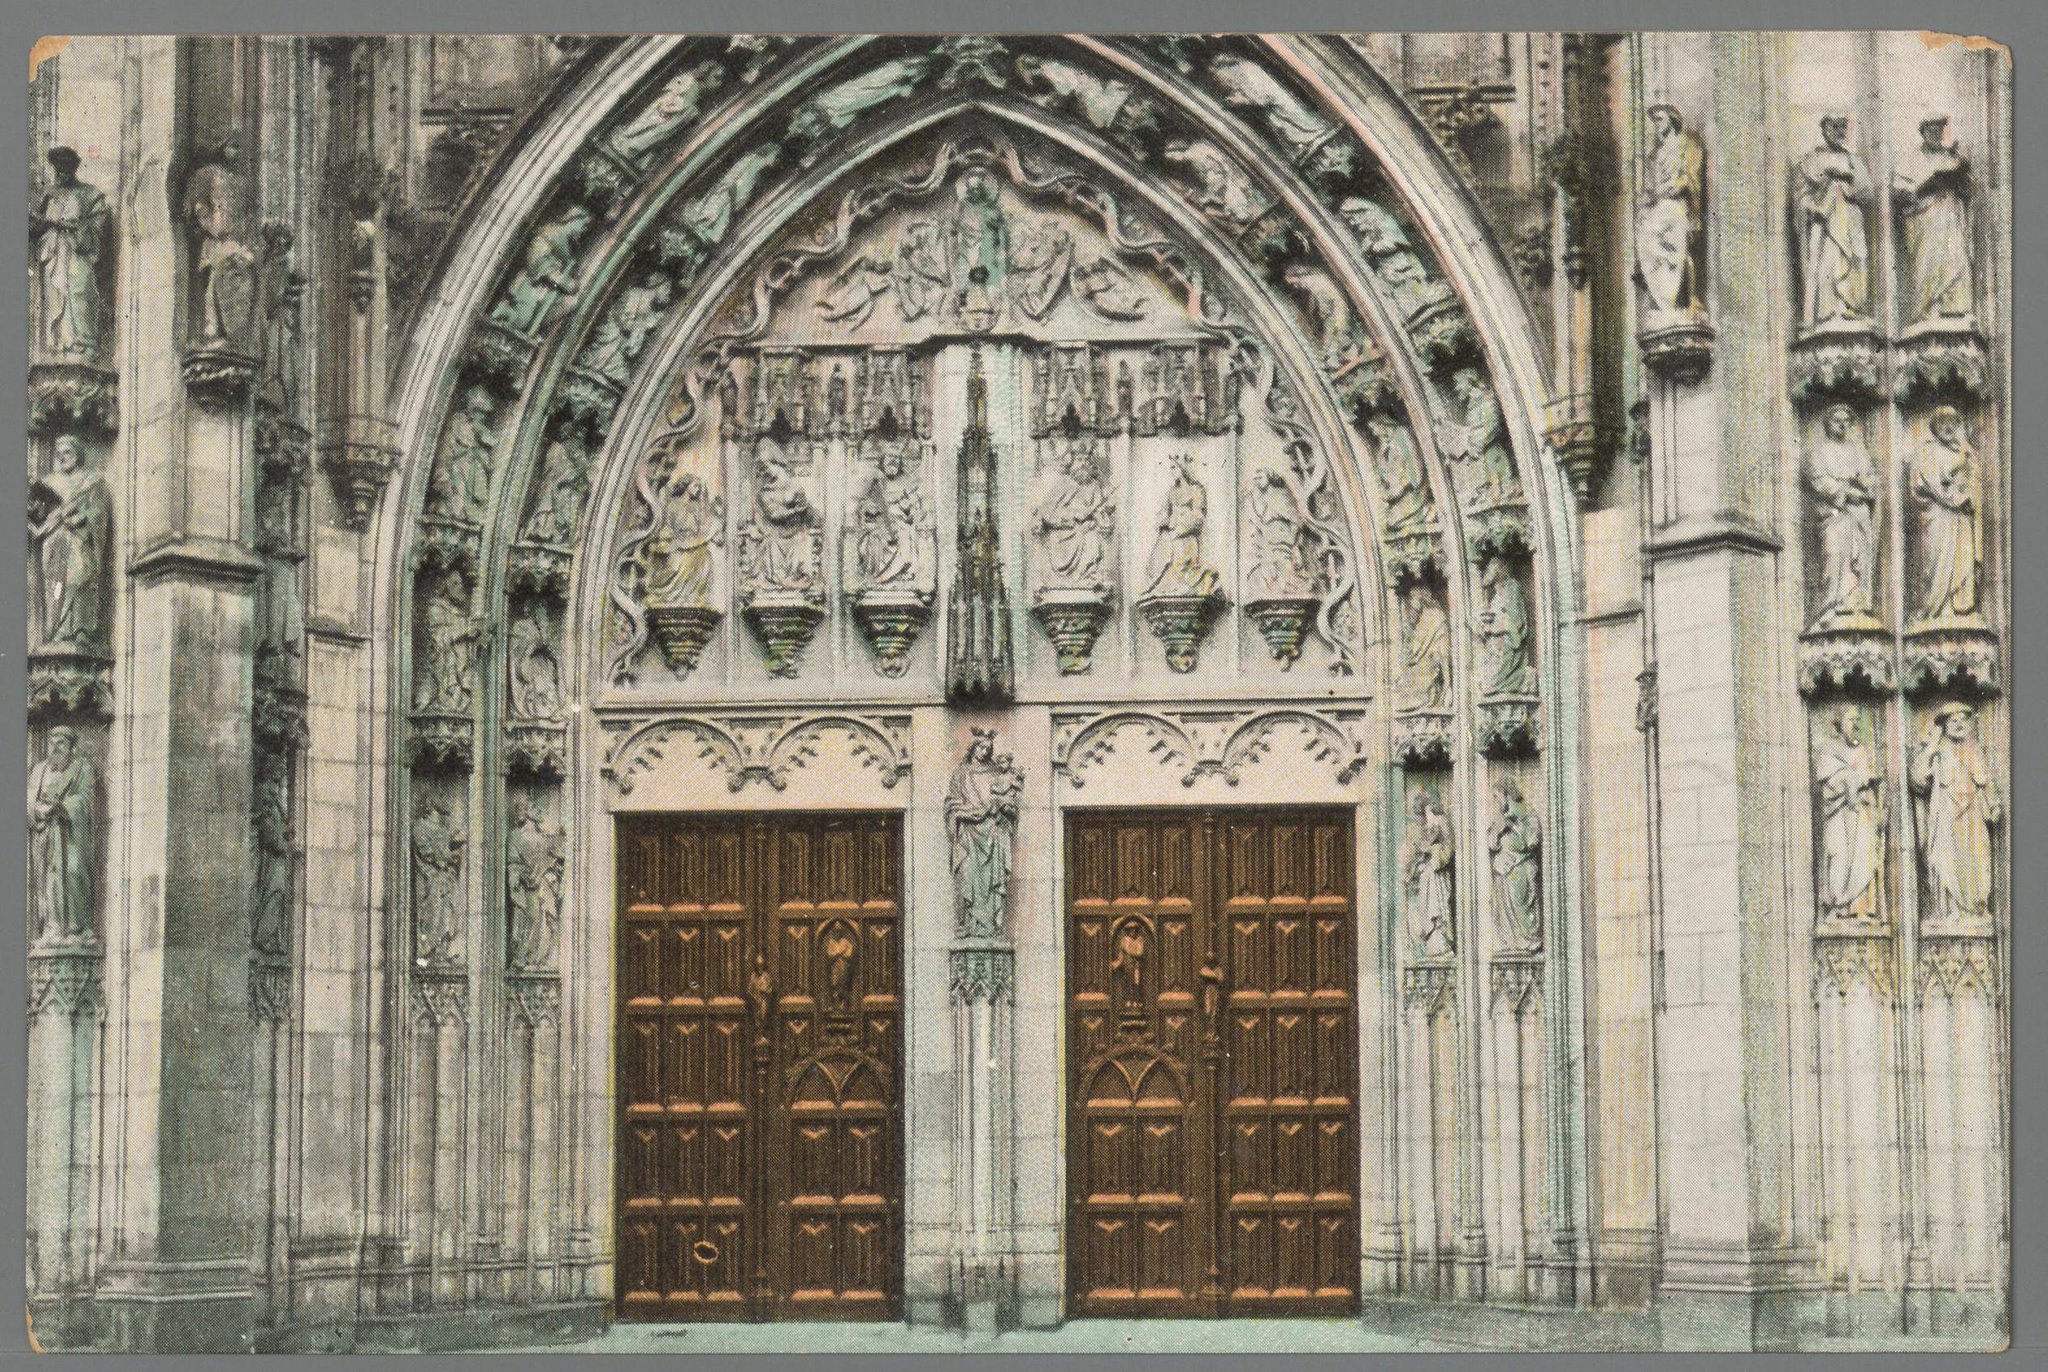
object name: ansichtkaart, prentbriefkaart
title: De St. Janskerk te 's Hertogenbosch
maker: Anonymous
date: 1905-1919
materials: cardboard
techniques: lithograph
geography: haarlem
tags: parts of church exterior and annexes: portal, church (exterior)